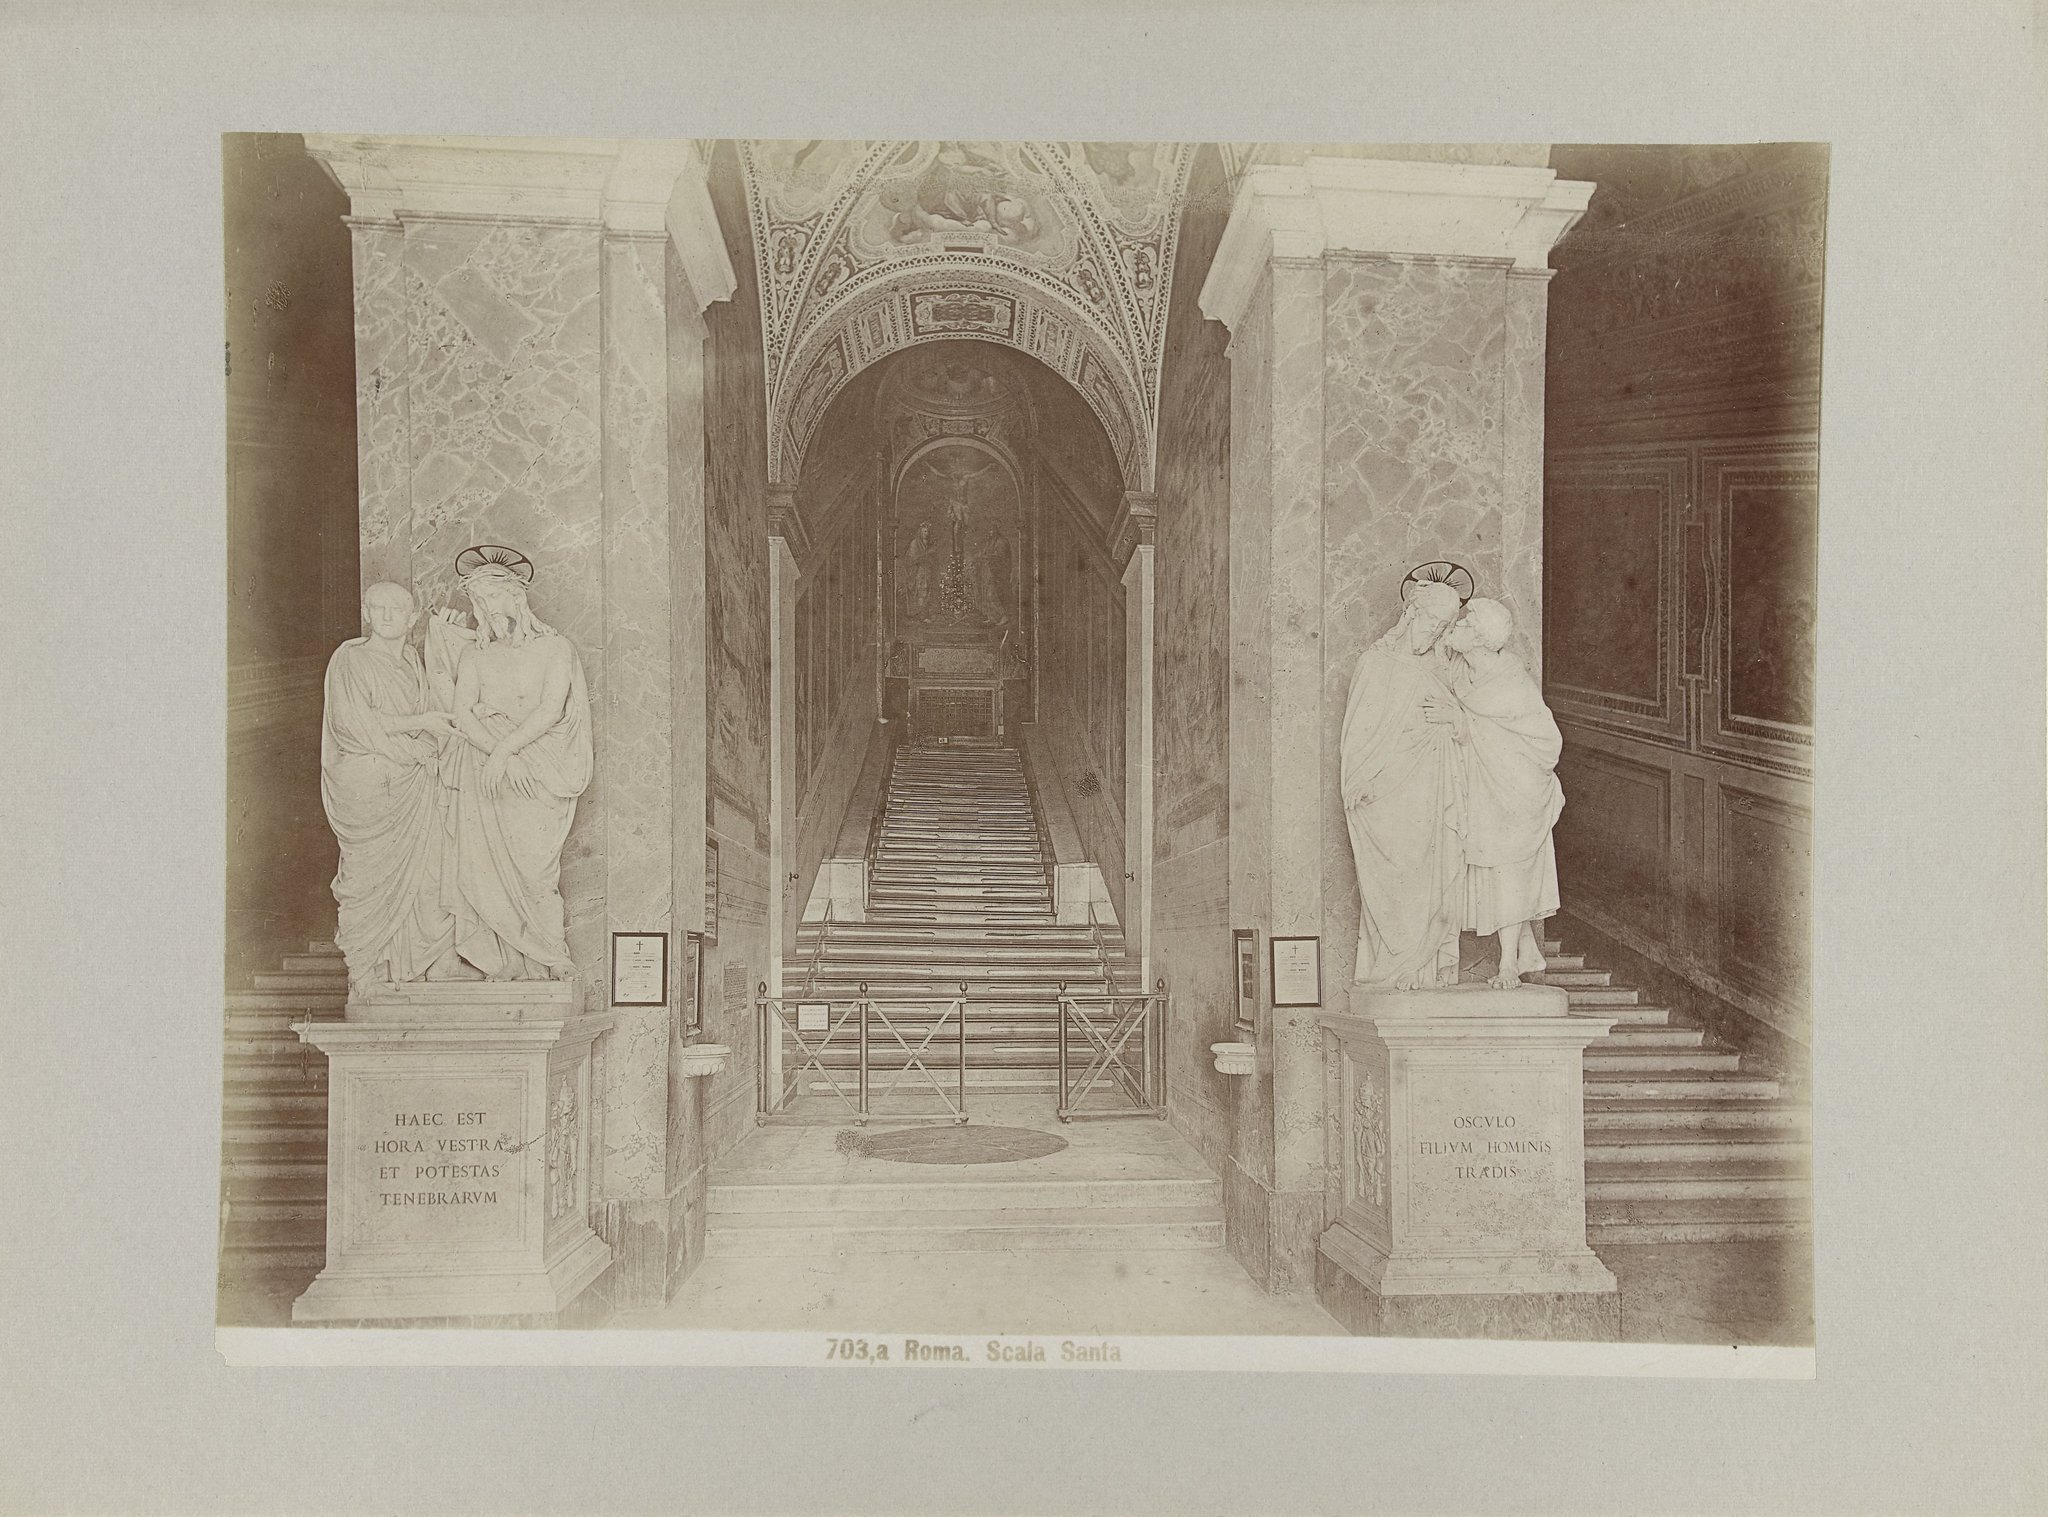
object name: photograph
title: 703,a Roma. Scala Santa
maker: Anonymous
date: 1880-1904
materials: cardboard, paper, photographic support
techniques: albumen print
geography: rome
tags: rome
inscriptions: number: ‘9.’